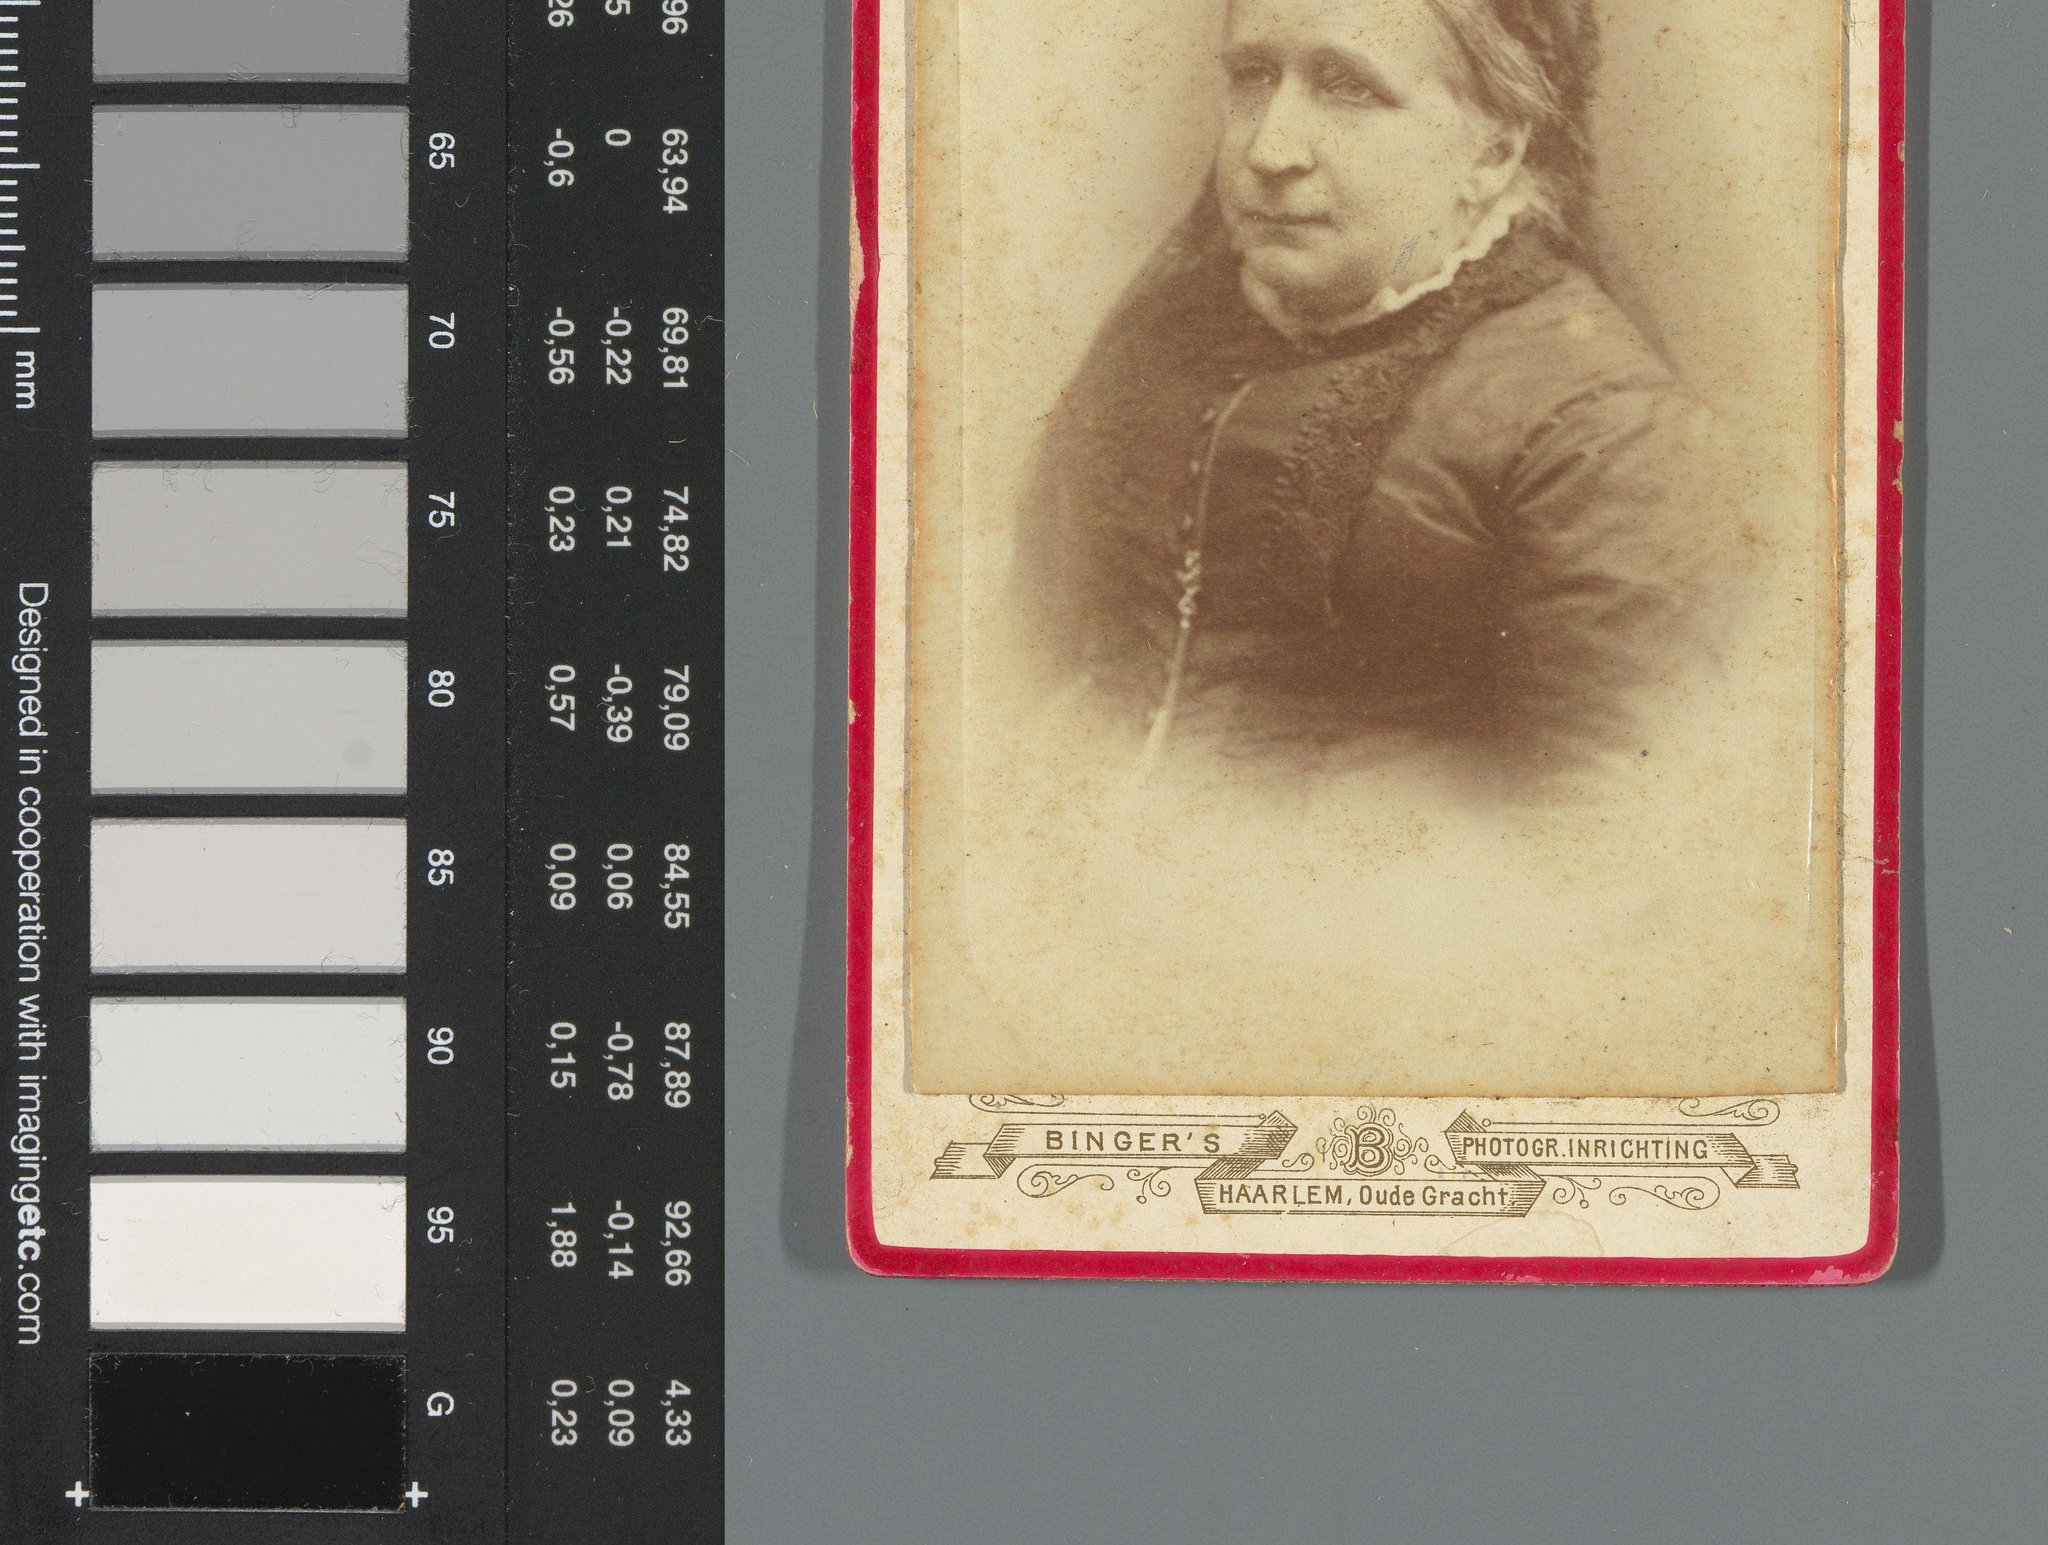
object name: carte de visite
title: Portret van Cornelia Elisabeth Teding van Berkhout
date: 1870-1887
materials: cardboard, photographic support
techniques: photography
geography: haarlem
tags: haarlem, historical persons - bb - woman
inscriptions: annotation: ‘Keetje Valkenburg-TvB’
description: Portret van Cornelia Elisabeth (Keetje) van Valkenburg-Teding van Berkhout.